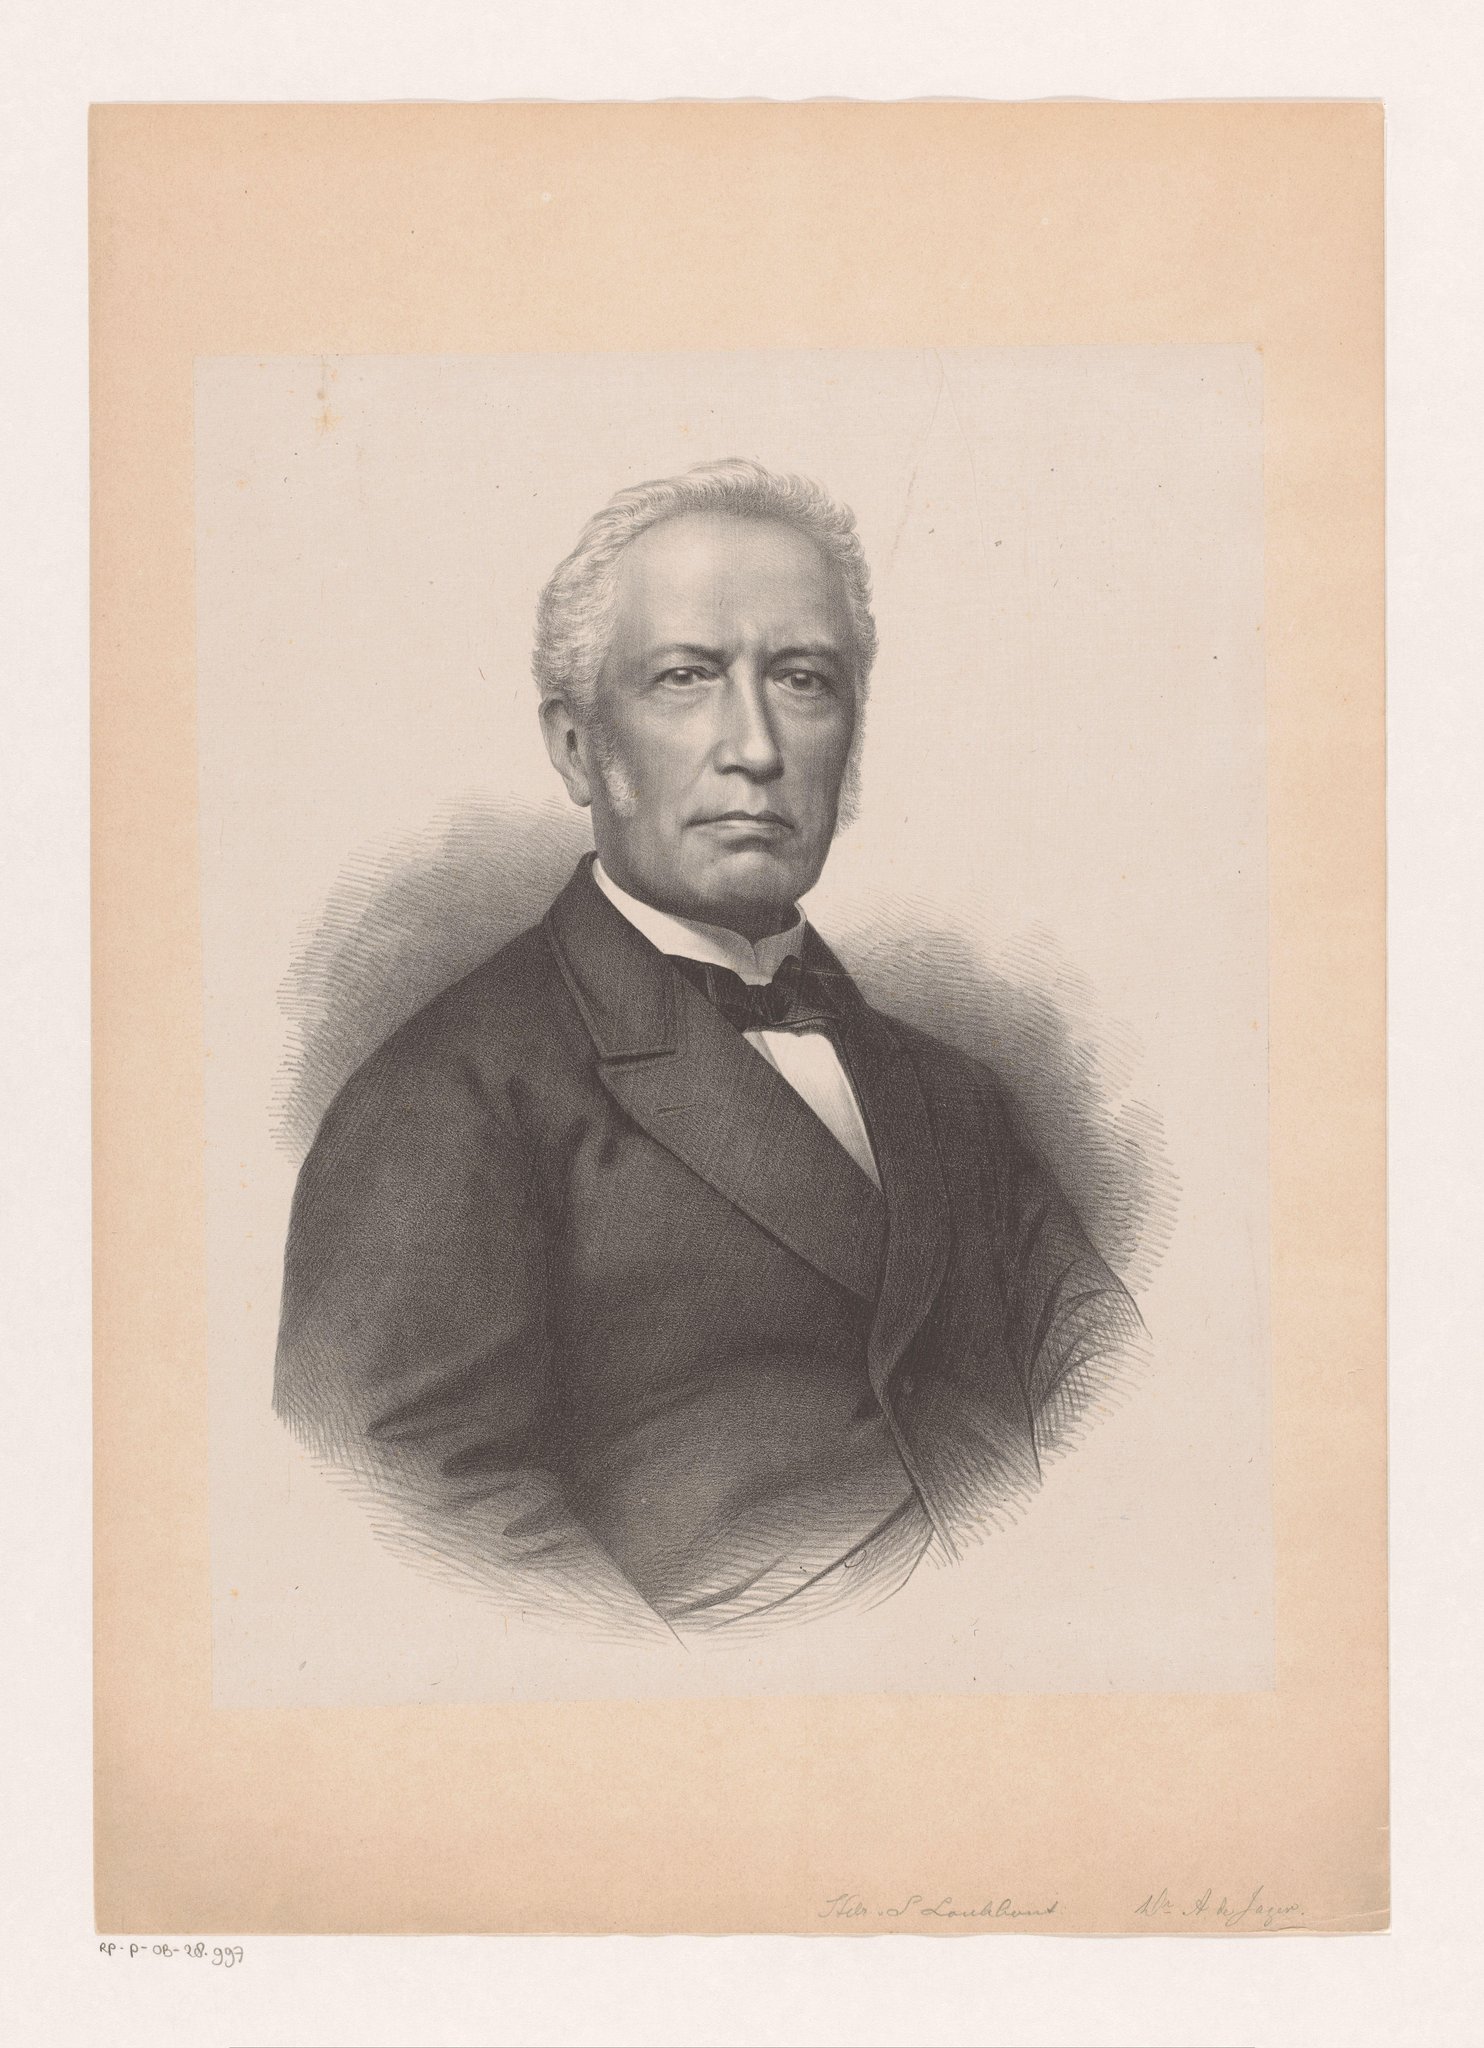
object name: print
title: Portret van Arie de Jager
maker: Anonymous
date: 1877-1903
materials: paper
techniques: lithograph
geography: the hague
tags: delfshaven, rotterdam, historical persons (+ (full) bust portrait)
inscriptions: collector's mark: Lugt 2228